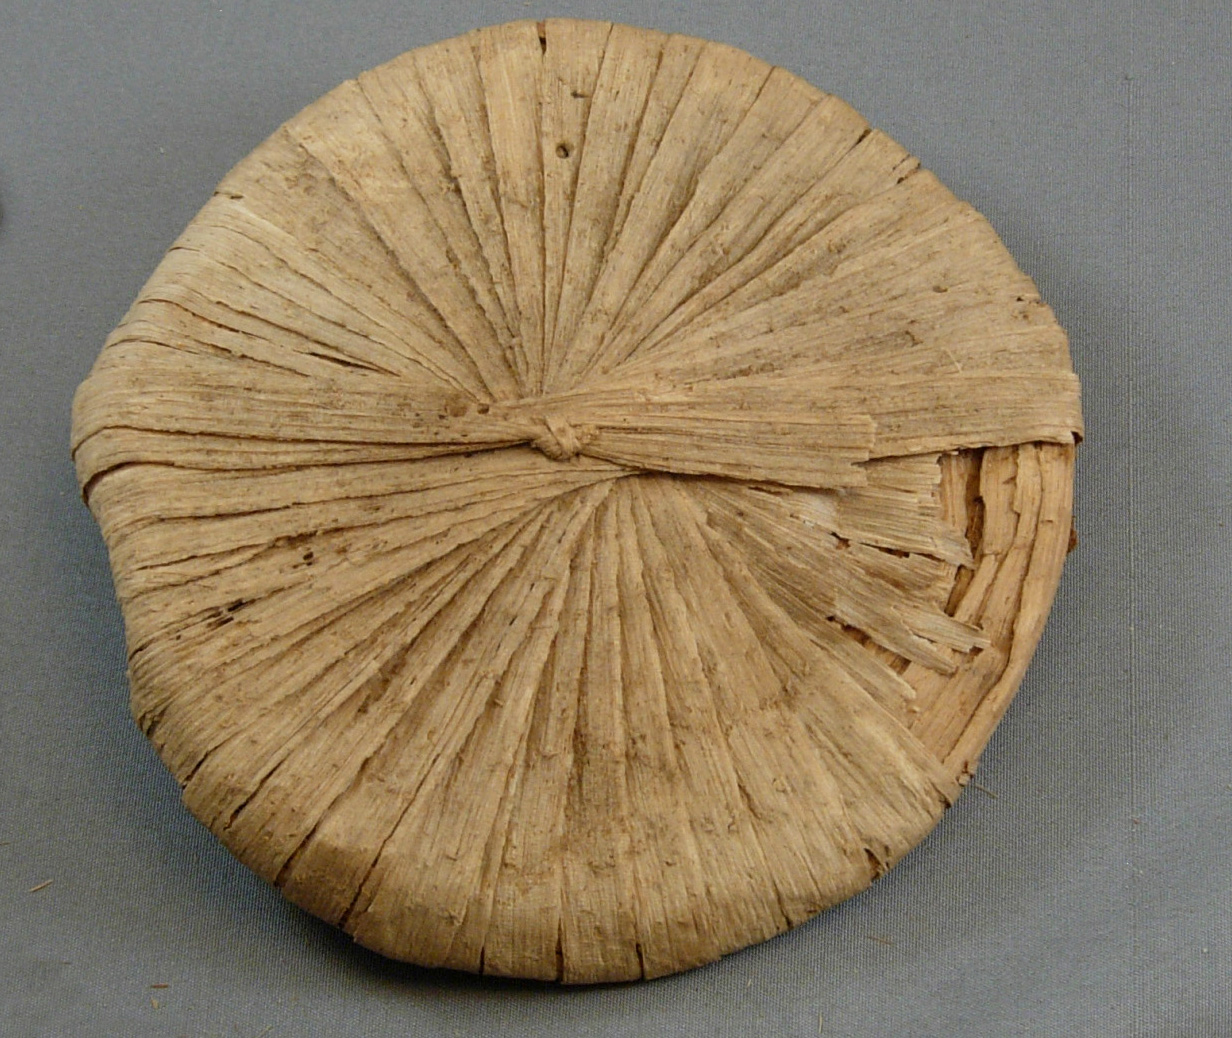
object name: jar lid, papyrus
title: Papyrus Lid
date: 1336-1327 BCE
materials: fiber, papyrus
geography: egypt